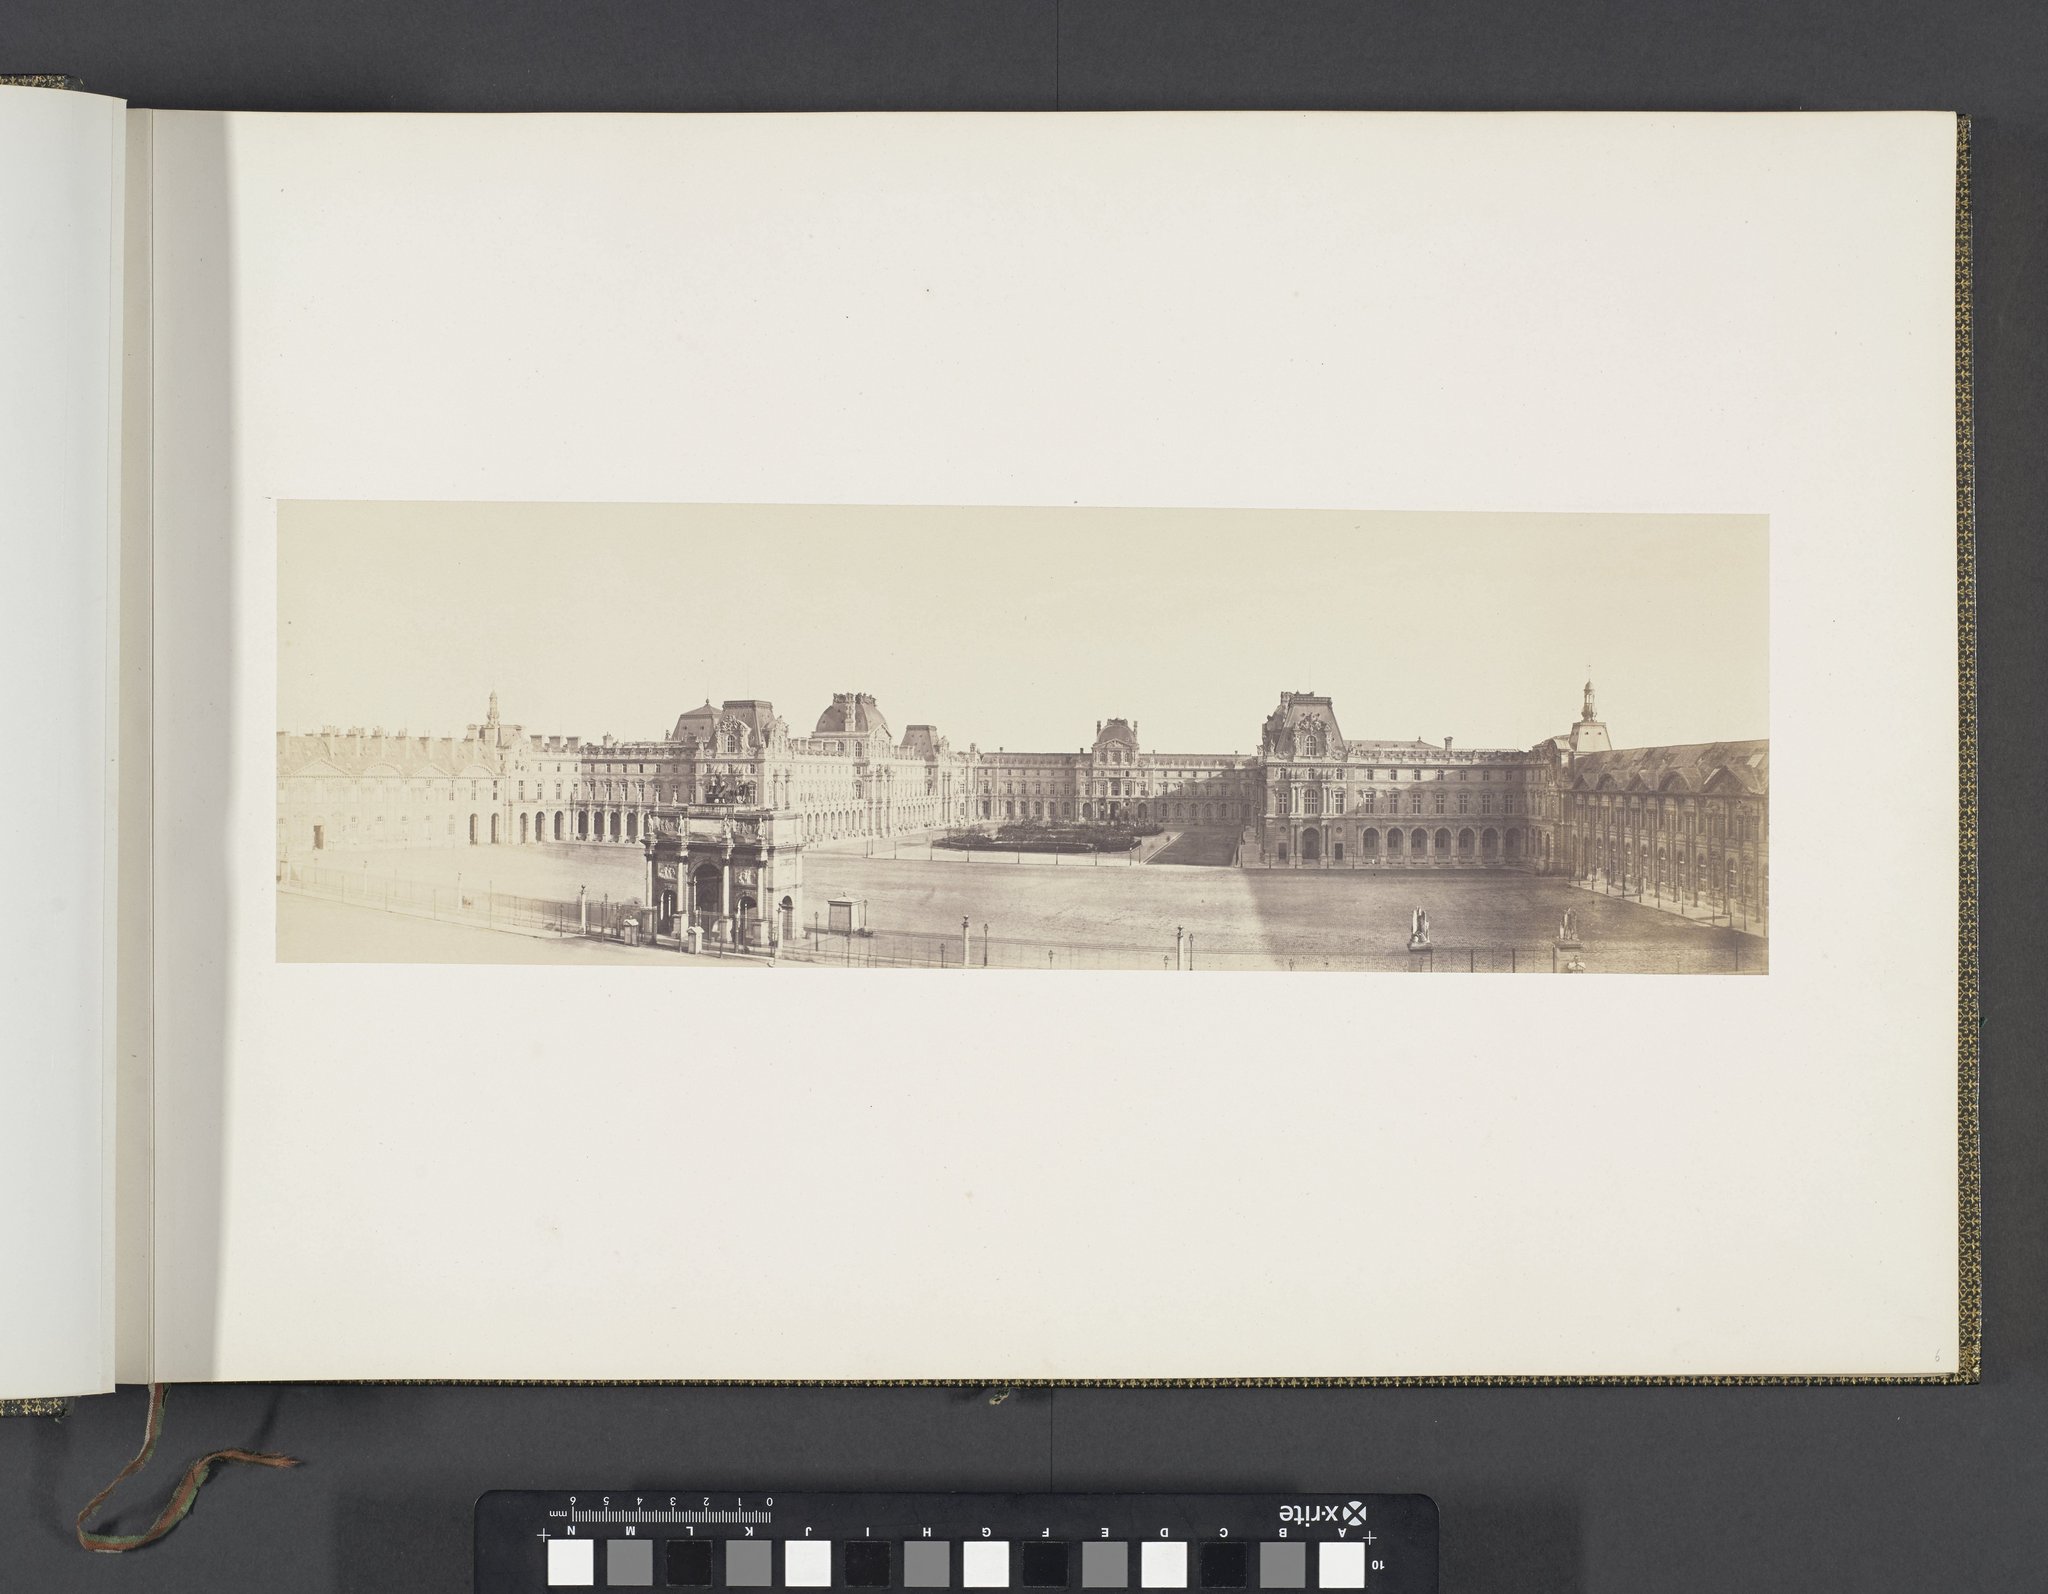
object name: photograph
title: Panorama van het Nieuwe Louvre: Tuilerieën, cour Napoléon en Carrousel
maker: édouard denis baldus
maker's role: fotograaf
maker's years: 1813-1889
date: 1857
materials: paper, photographic support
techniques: salted paper print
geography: paris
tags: permanent exhibition, museum, paris, tuileries palace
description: Onderdeel van Réunion des Tuileries au Louvre 1852-1857, album 1.